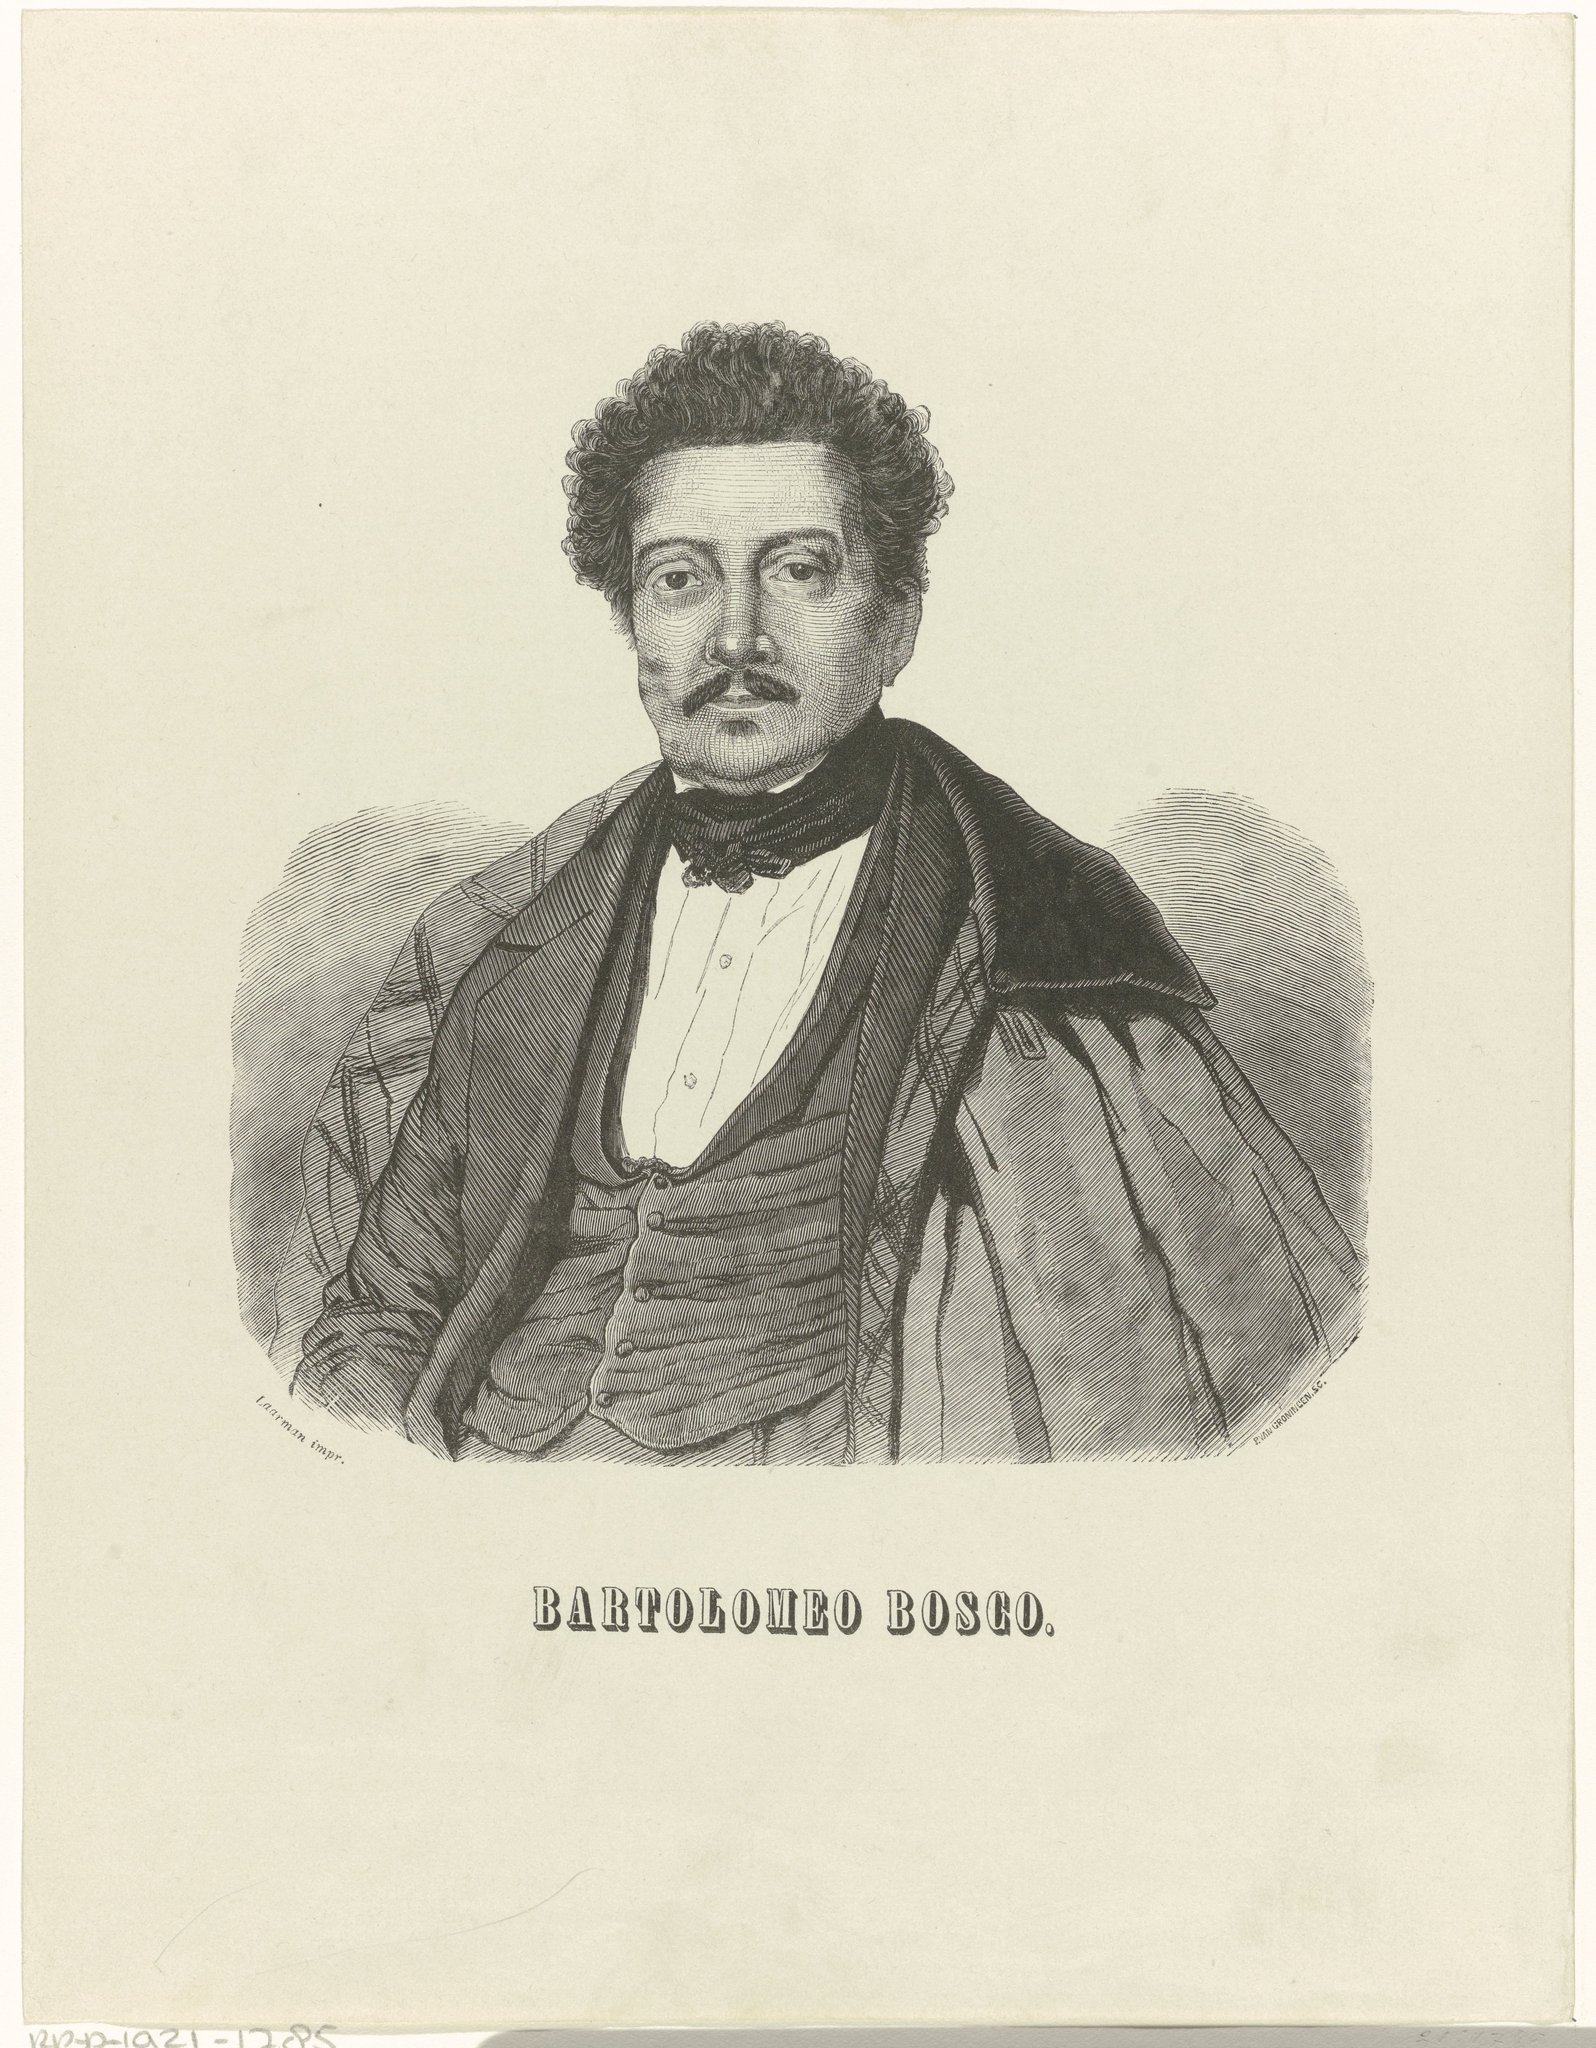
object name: print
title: Portret van Giovanni Bartolomeo Bosco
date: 1834-1878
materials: paper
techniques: engraving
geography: amsterdam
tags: turijn, giovanni bartolomeo bosco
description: Portret van Giovanni Bartolomeo Bosco. In de ondermarge zijn naam.